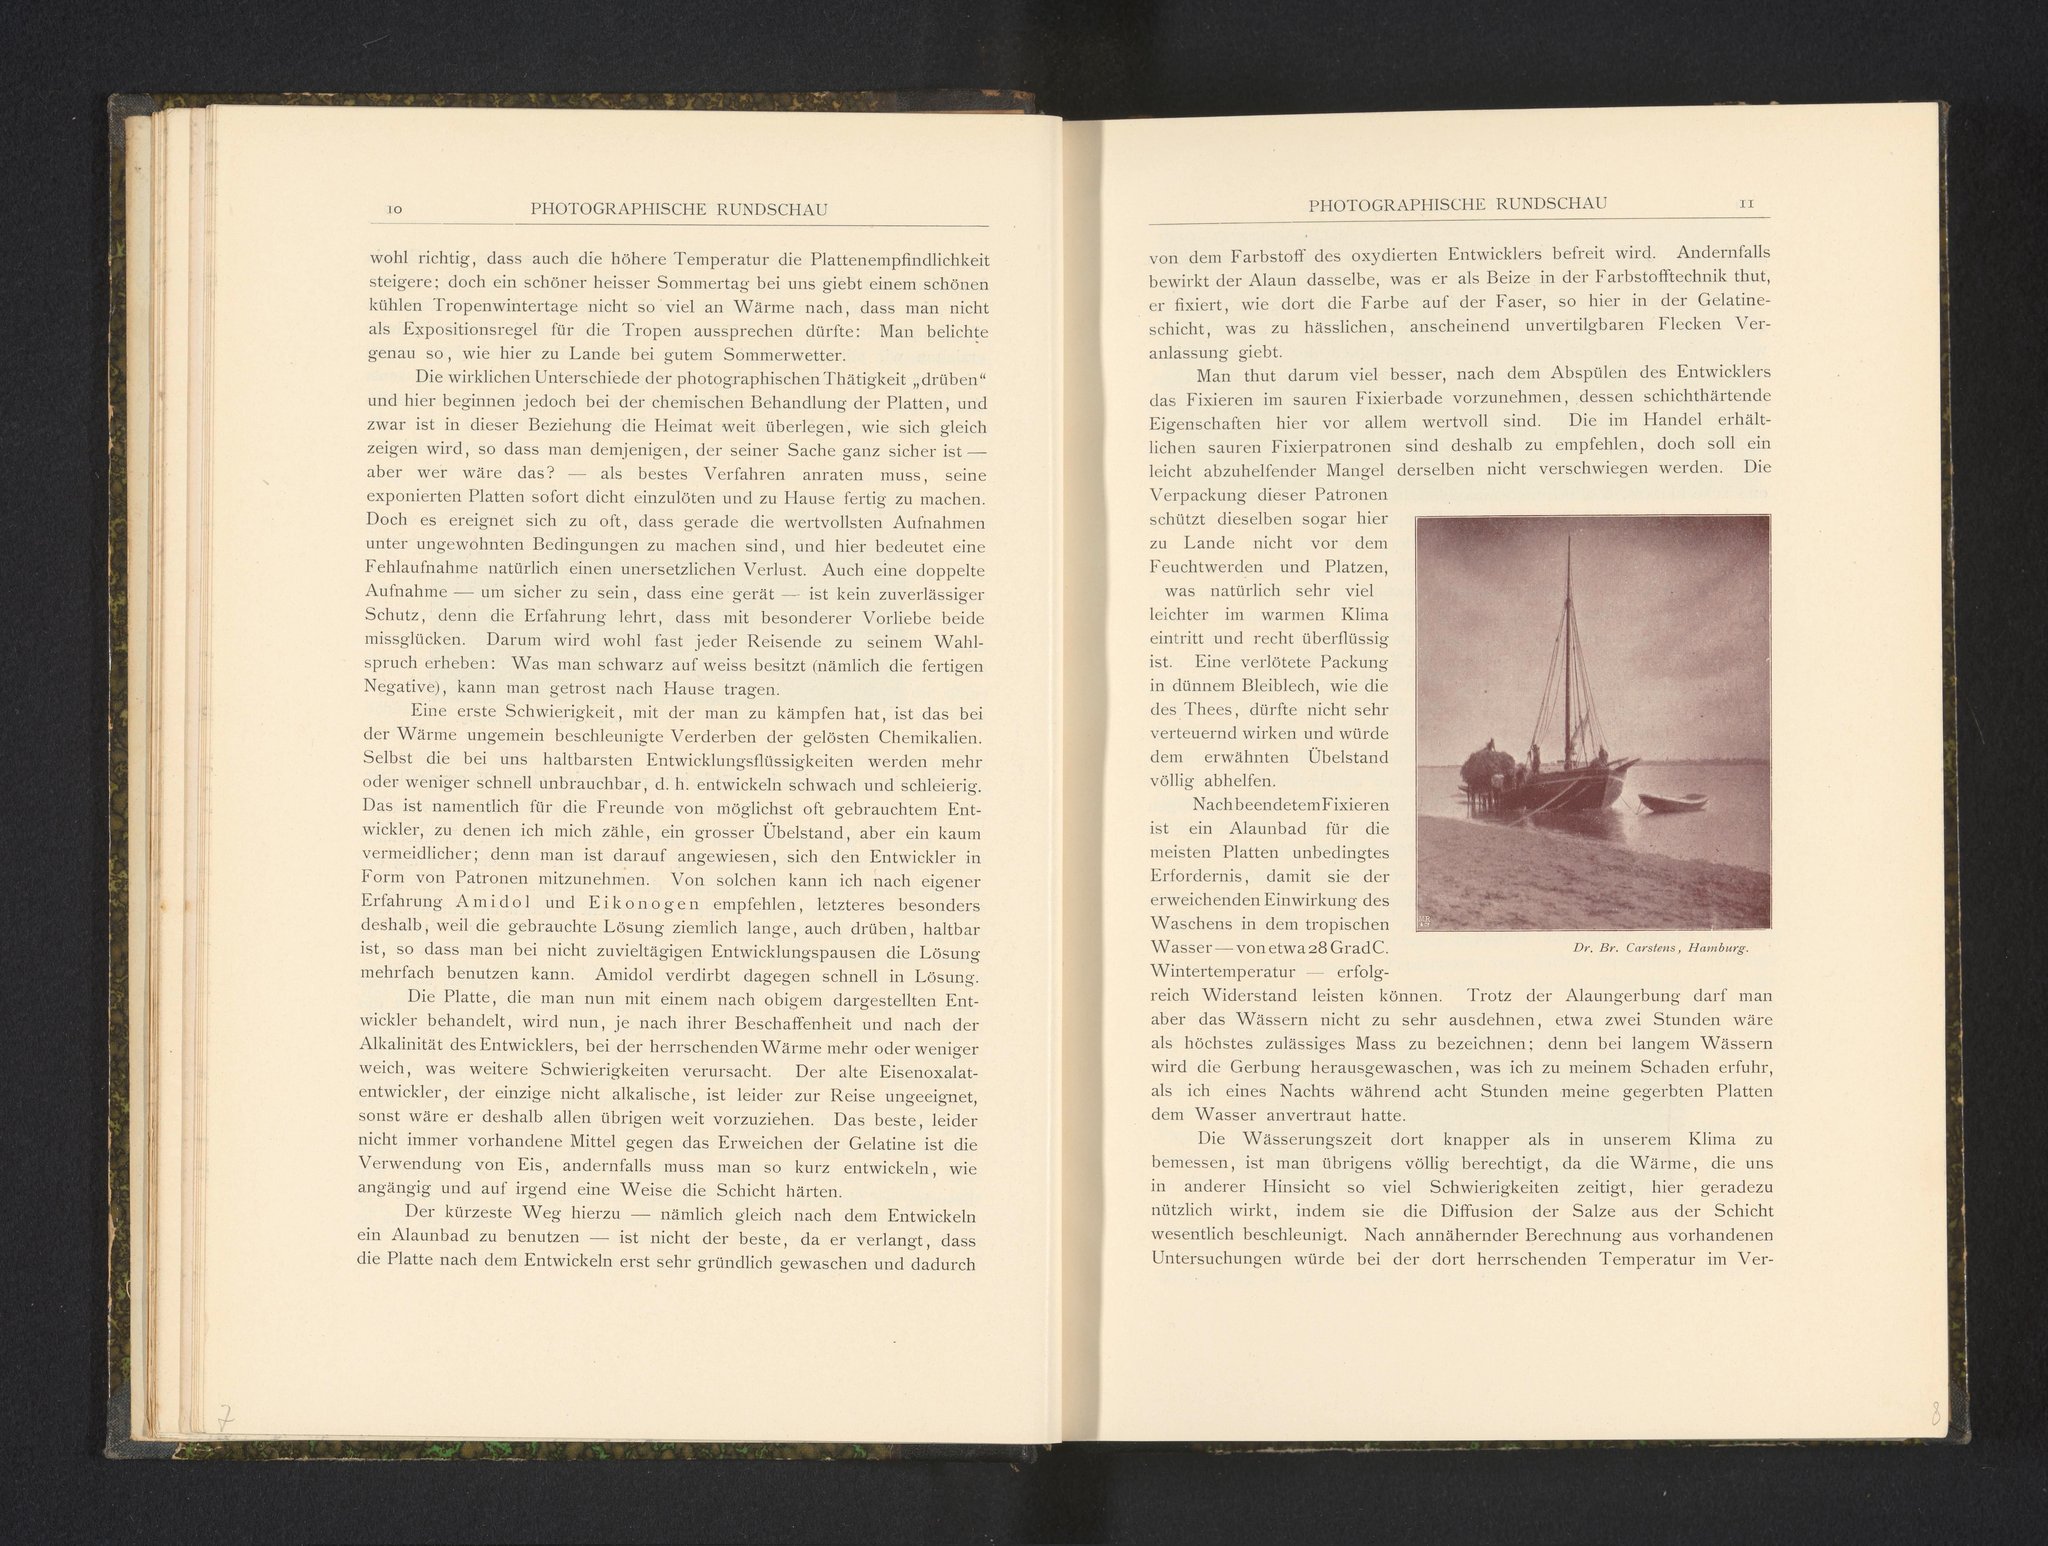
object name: page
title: Zeilschip voor de kust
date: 1893-1898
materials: paper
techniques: autotype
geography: hamburg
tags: sailing-ship, sailing-boat